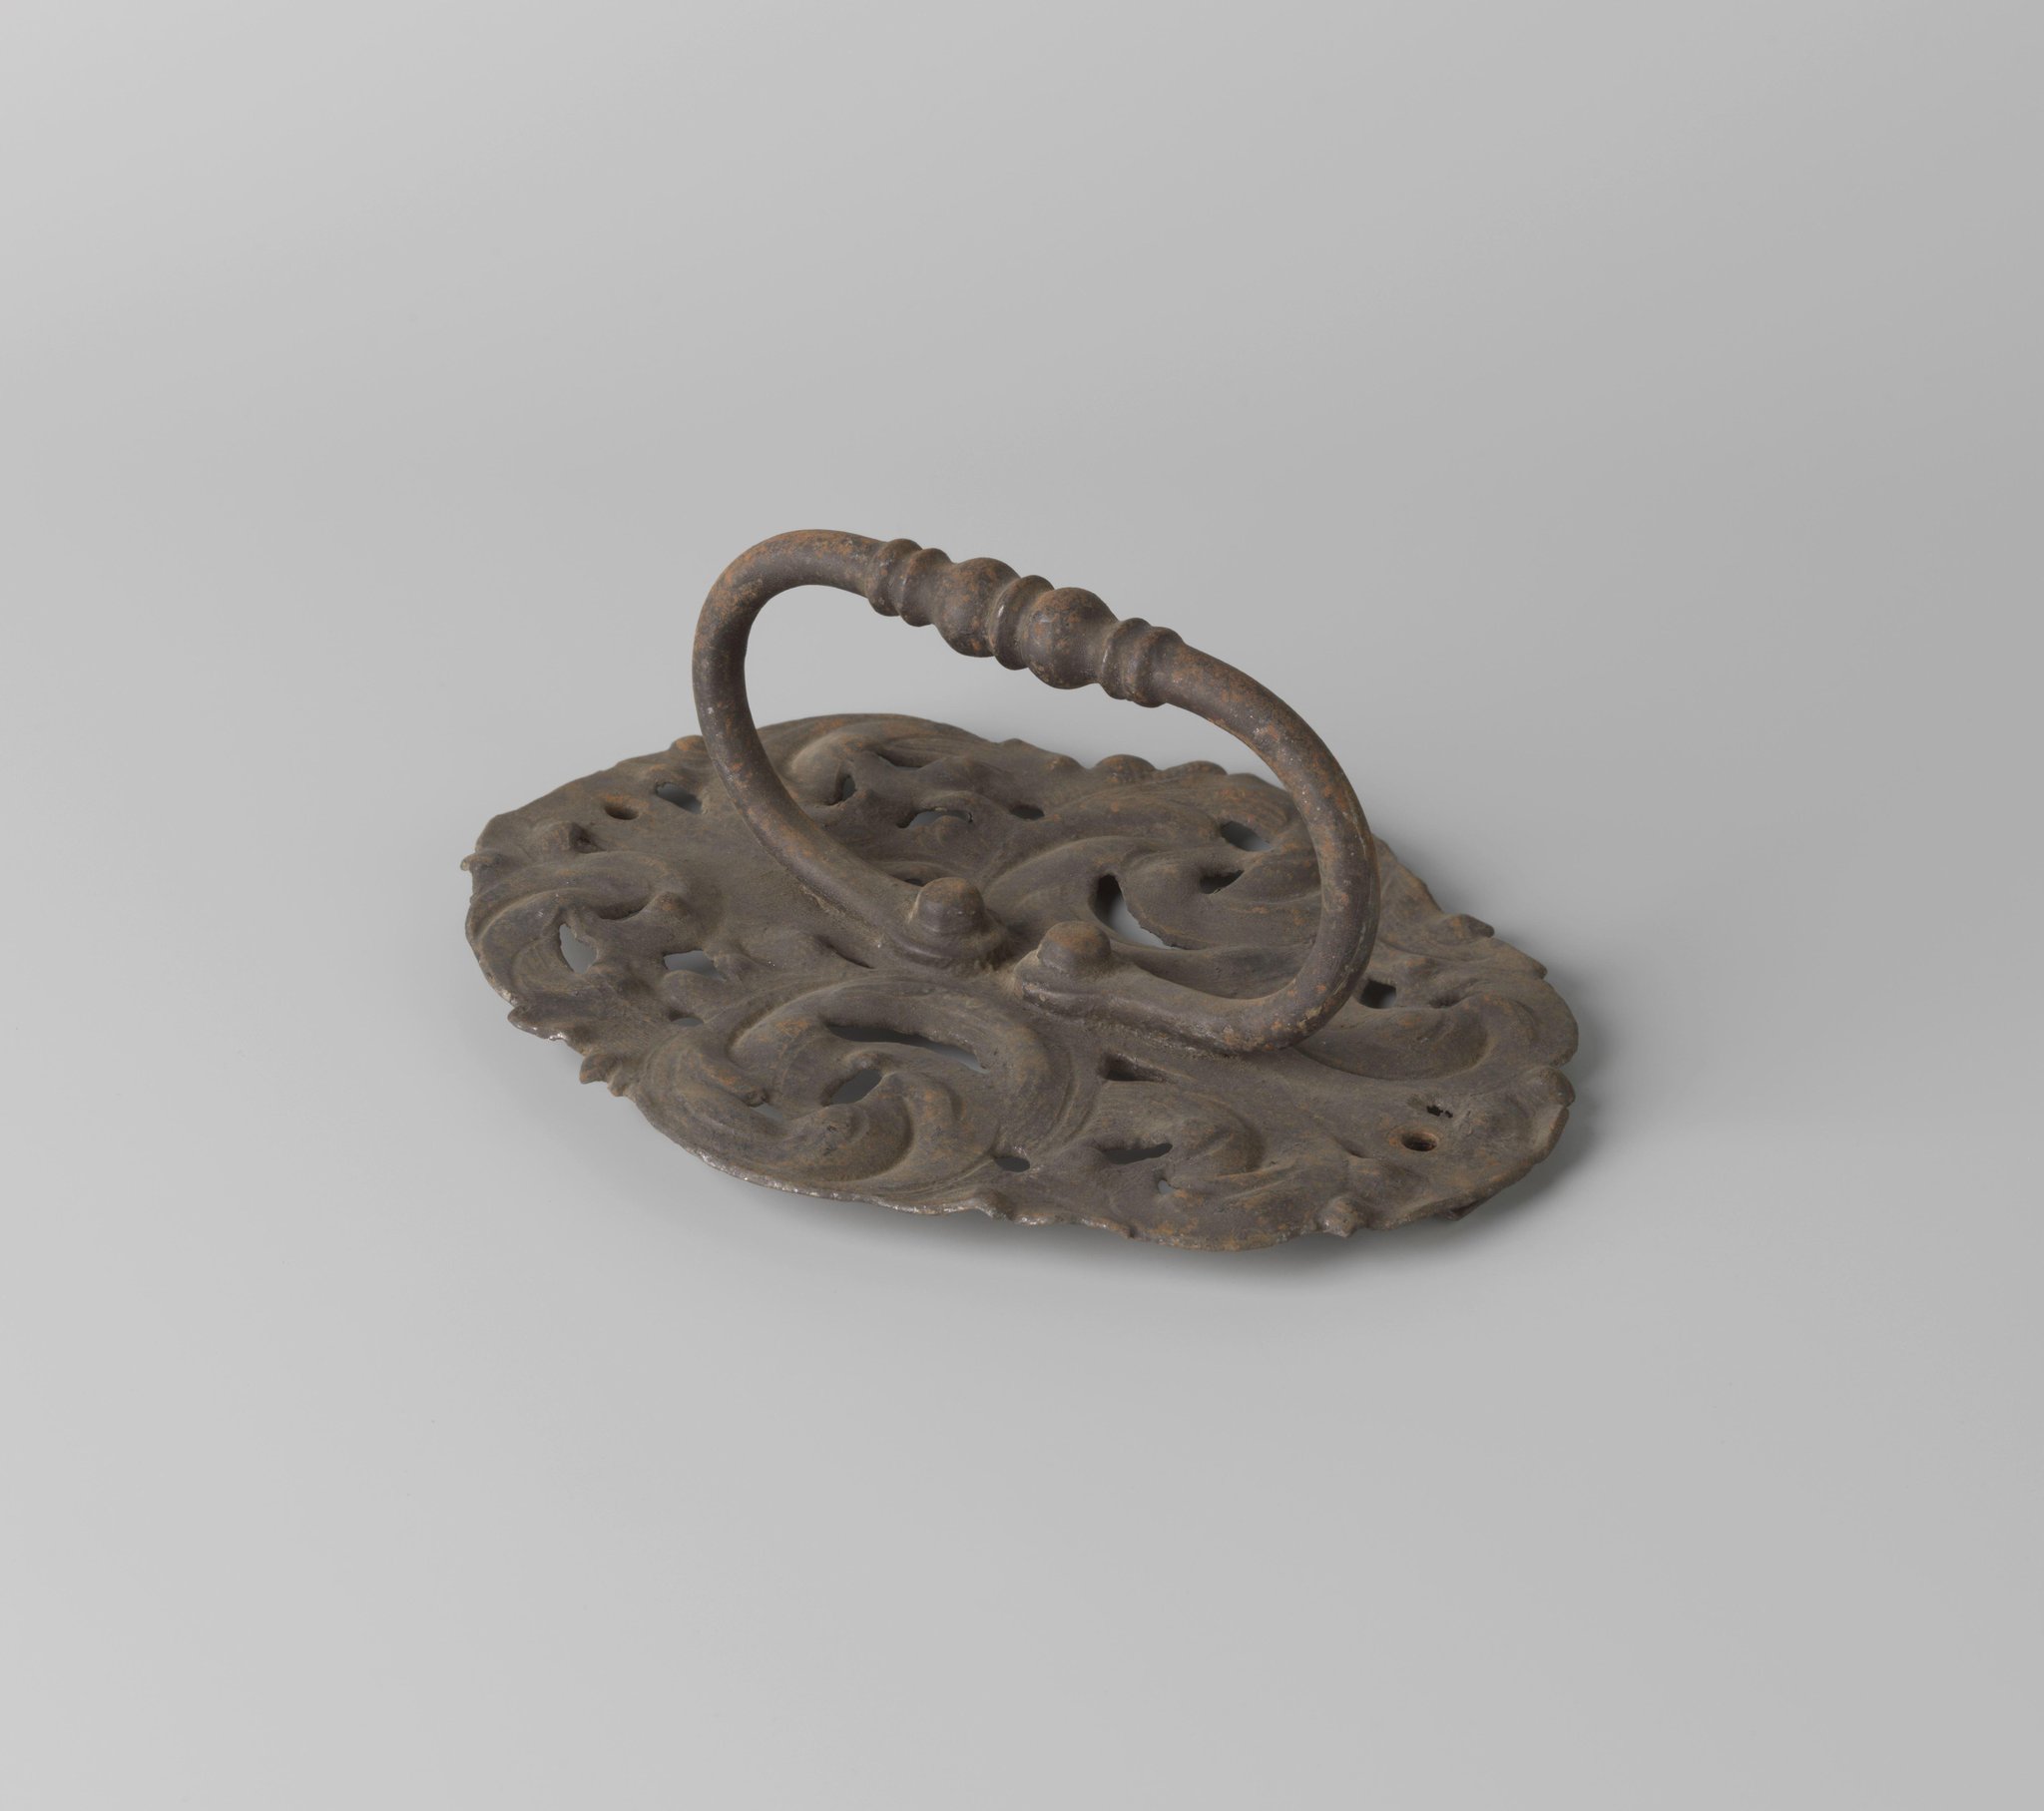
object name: trekker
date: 1400-1950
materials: iron